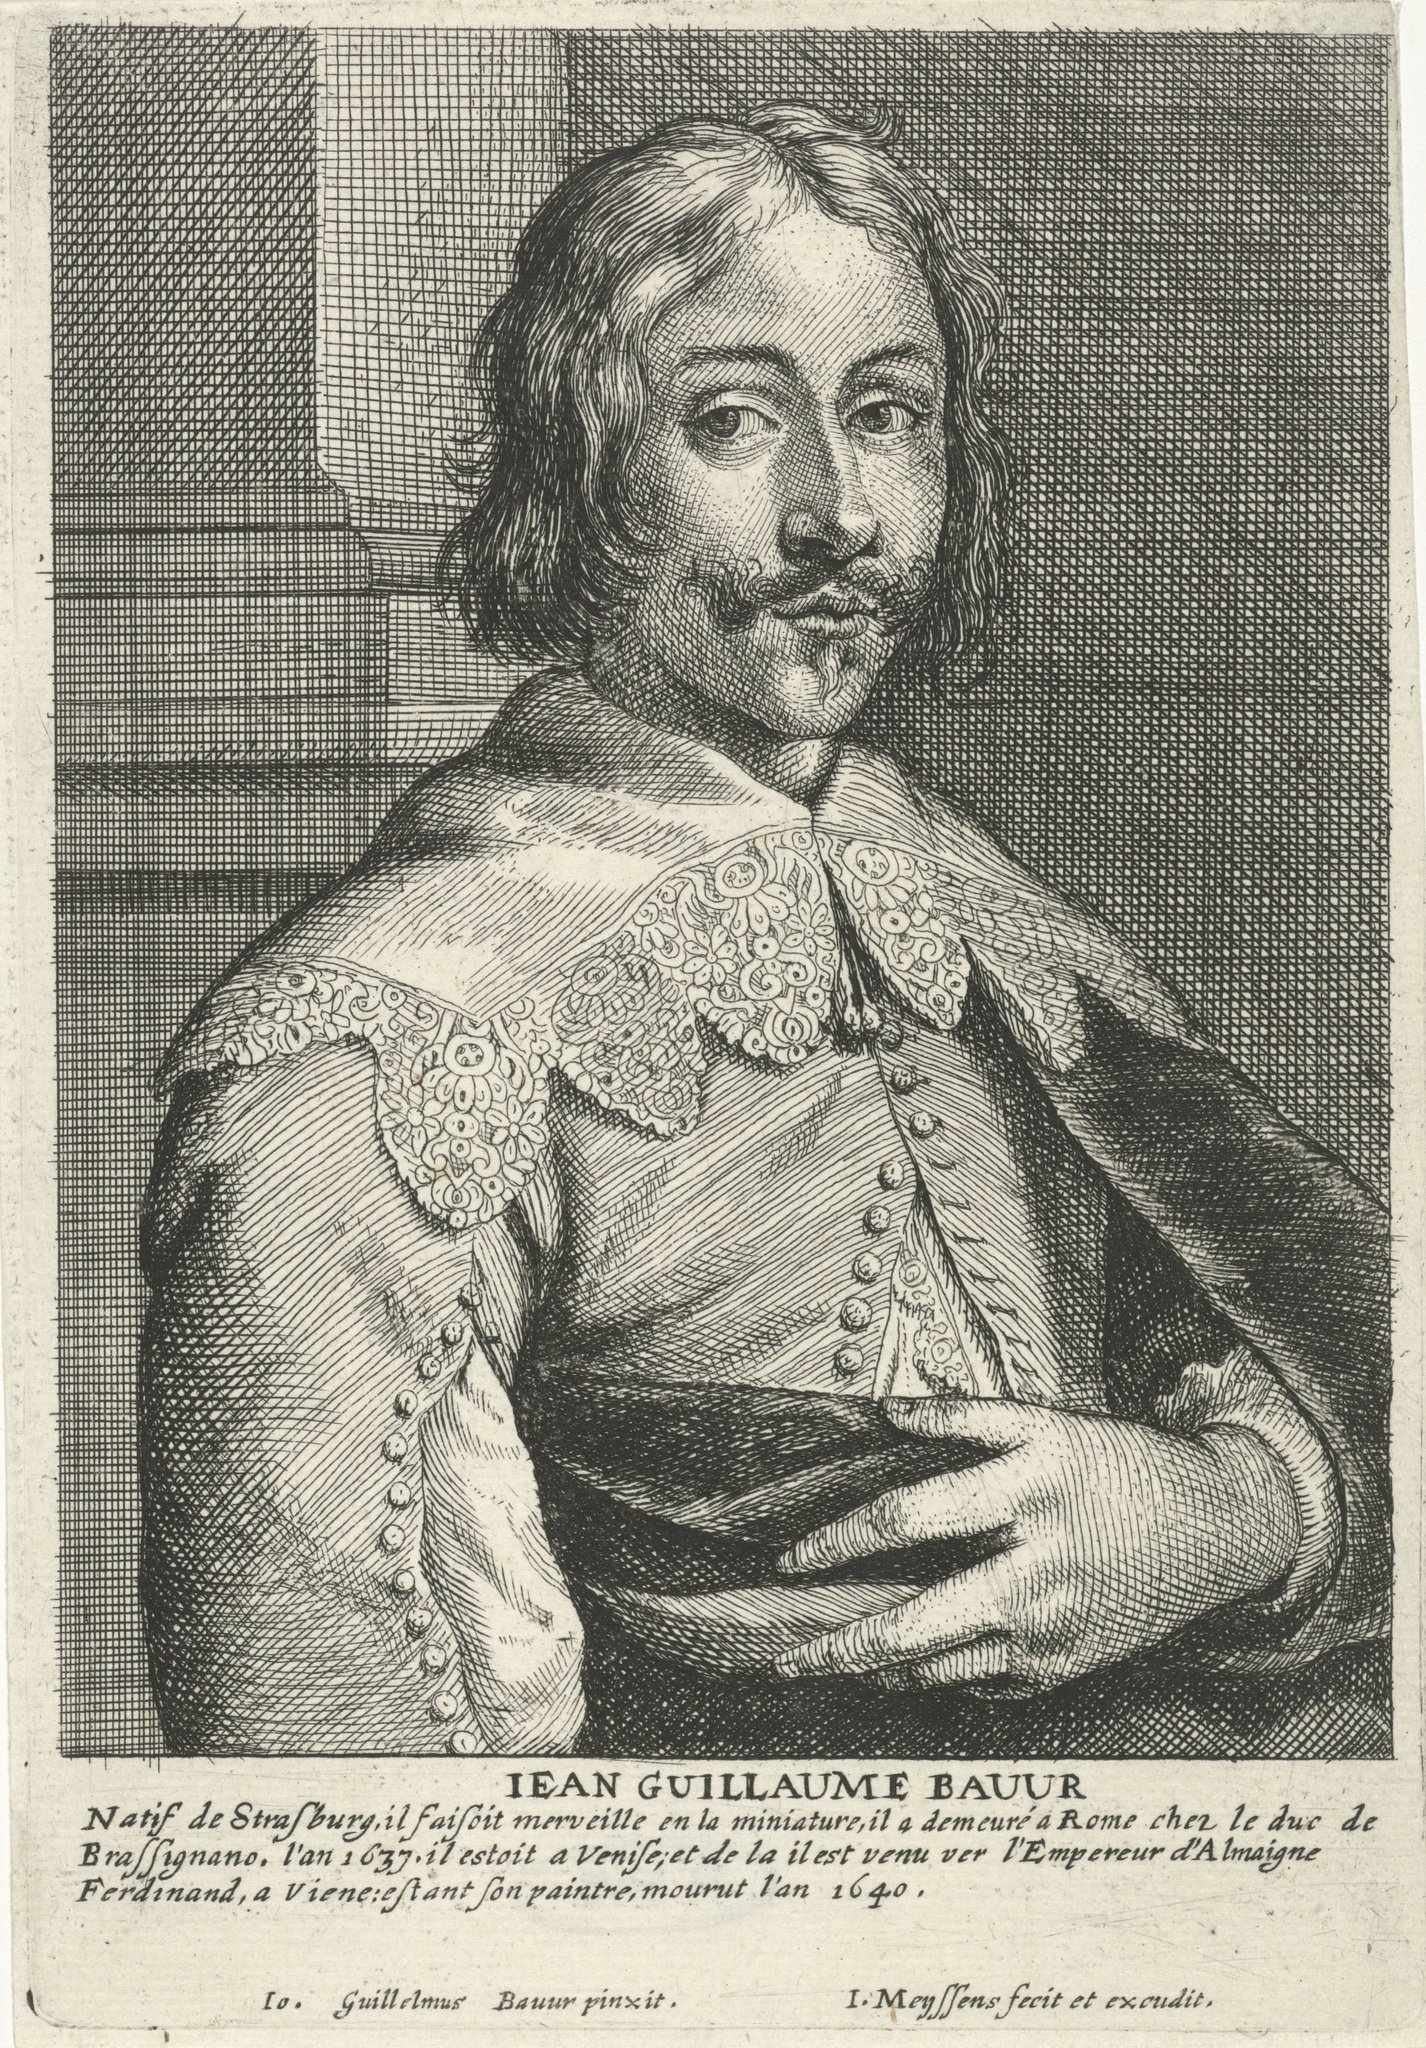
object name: book illustration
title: Portret van Johann Wilhelm Baur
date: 1662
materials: paper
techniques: engraving, etching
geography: antwerp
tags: vienna, painter, draughtsman, johann wilhelm baur, portrait, self-portrait of artist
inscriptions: collector's mark: Lugt 2228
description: Prent uit: Bie, Cornelis de. Het gulden cabinet vande edele vry schilder-const. 3 dln. Antwerpen: Joannes Meyssens en Juliaen van Montfort, 1662, dl. 1, p. 113.